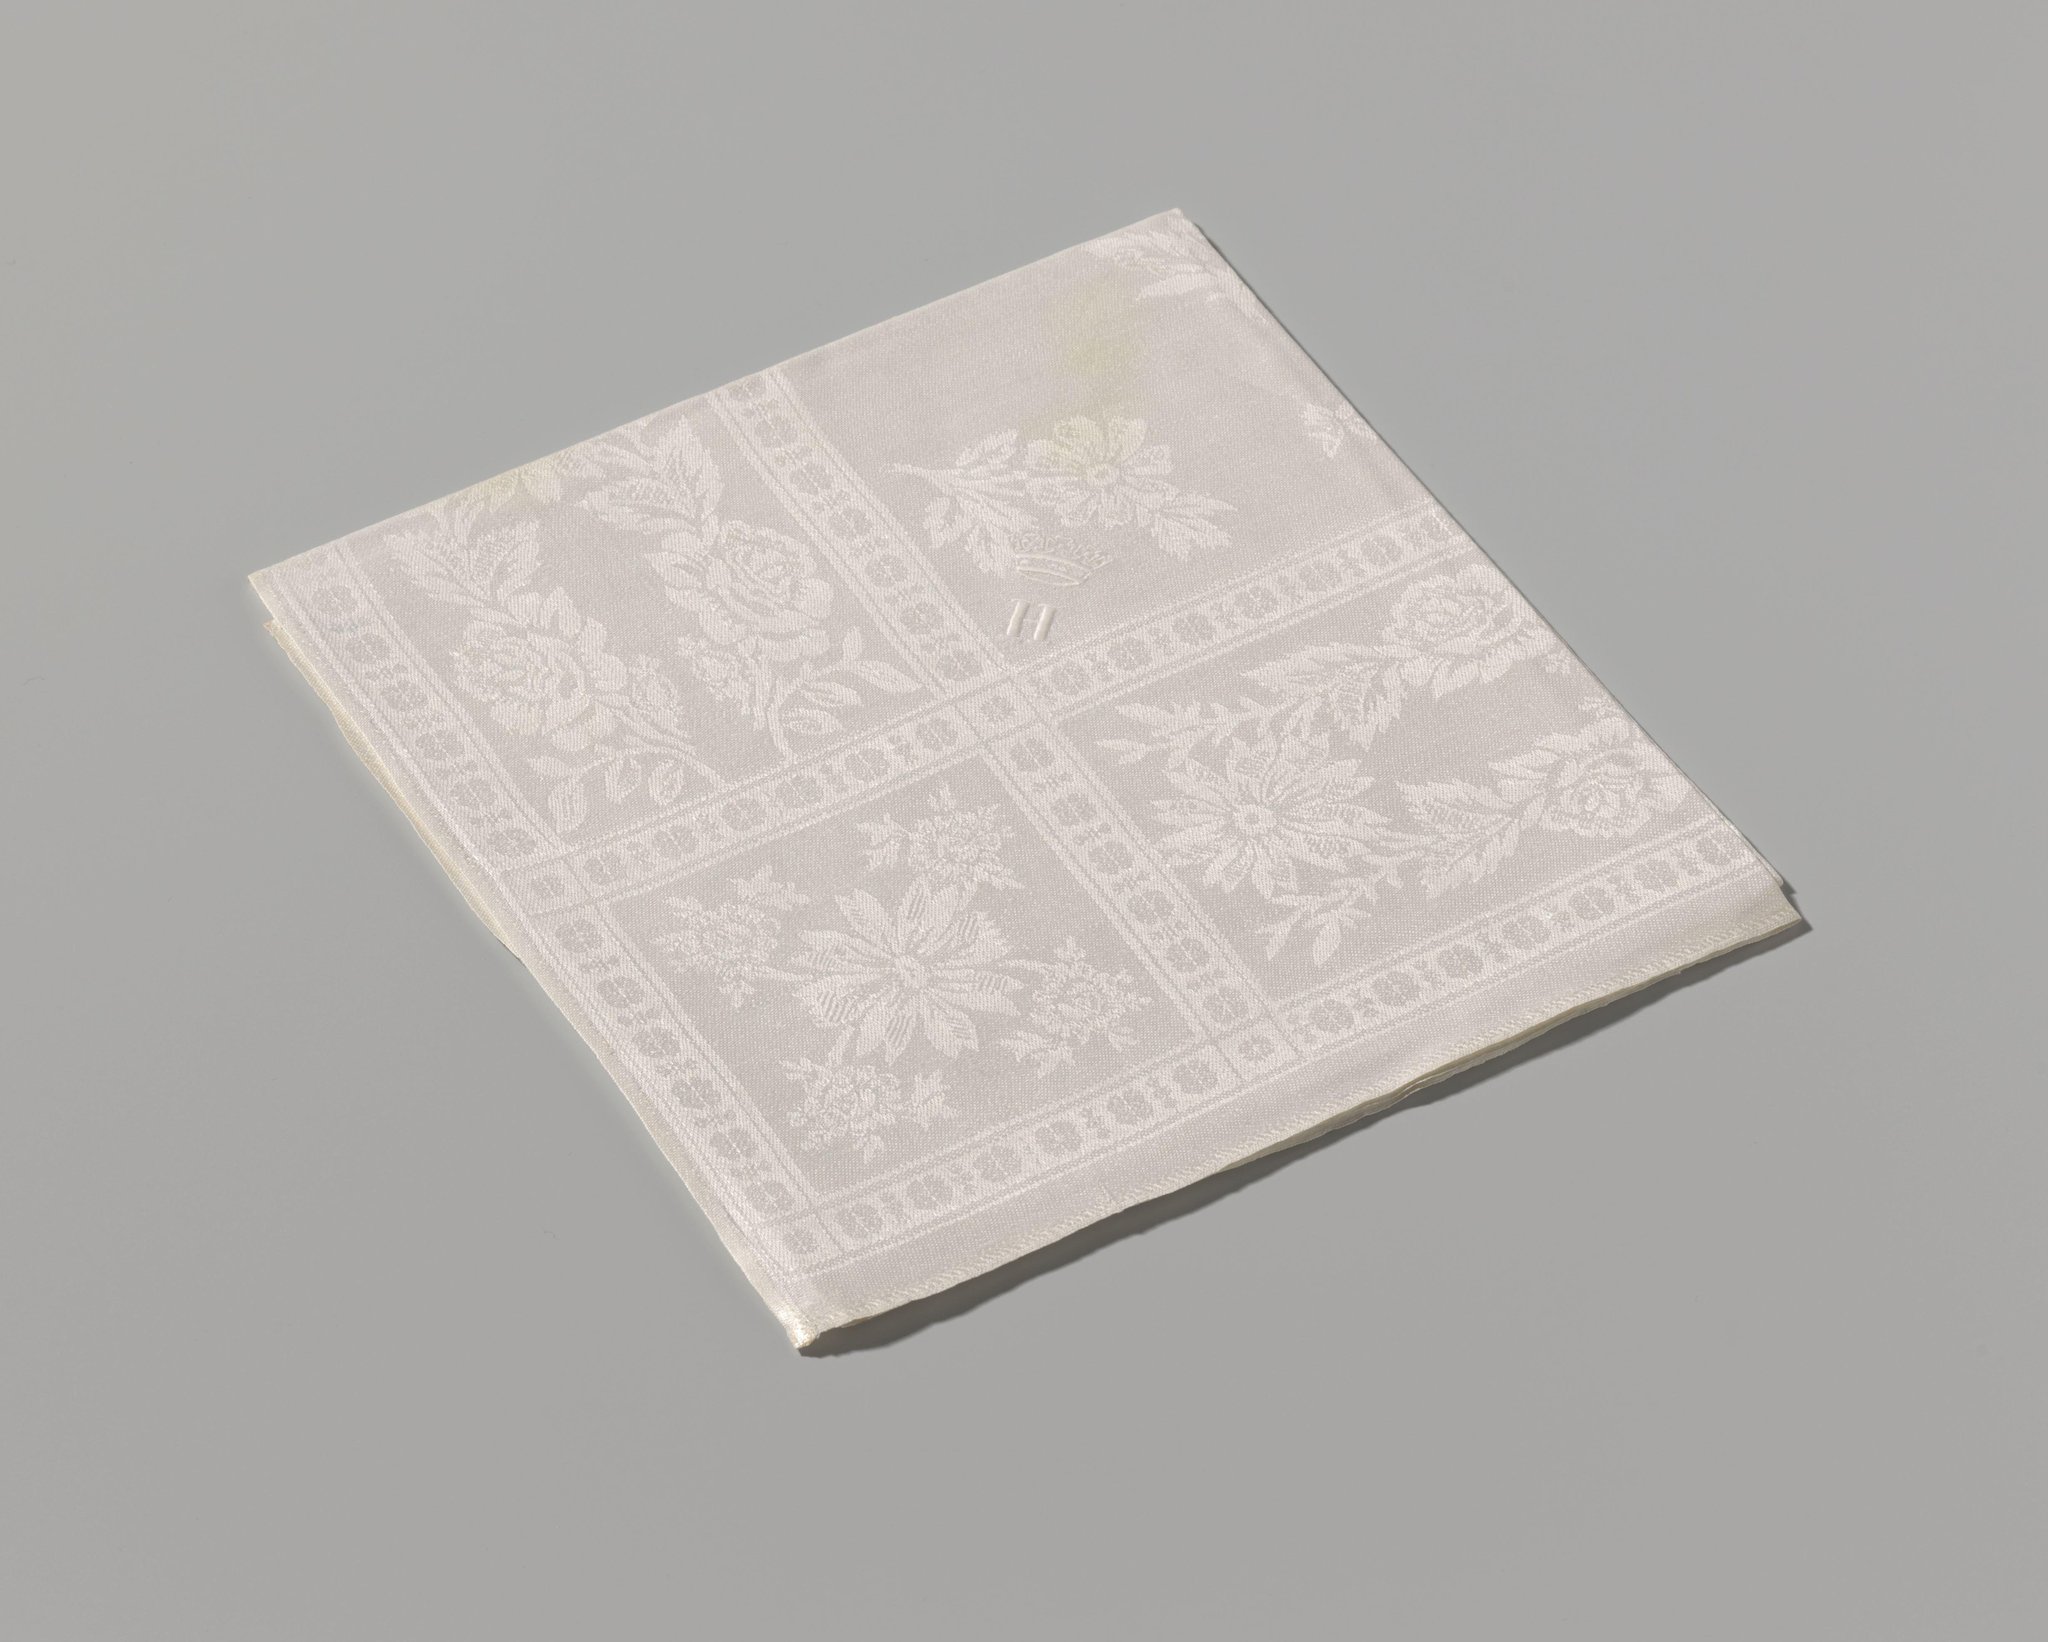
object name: napkin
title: Servet van wit linnendamast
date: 1859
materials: linen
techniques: damask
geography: borne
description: Wit linnen damasten servet met "grote en kleine bloemen", merk kroon H.